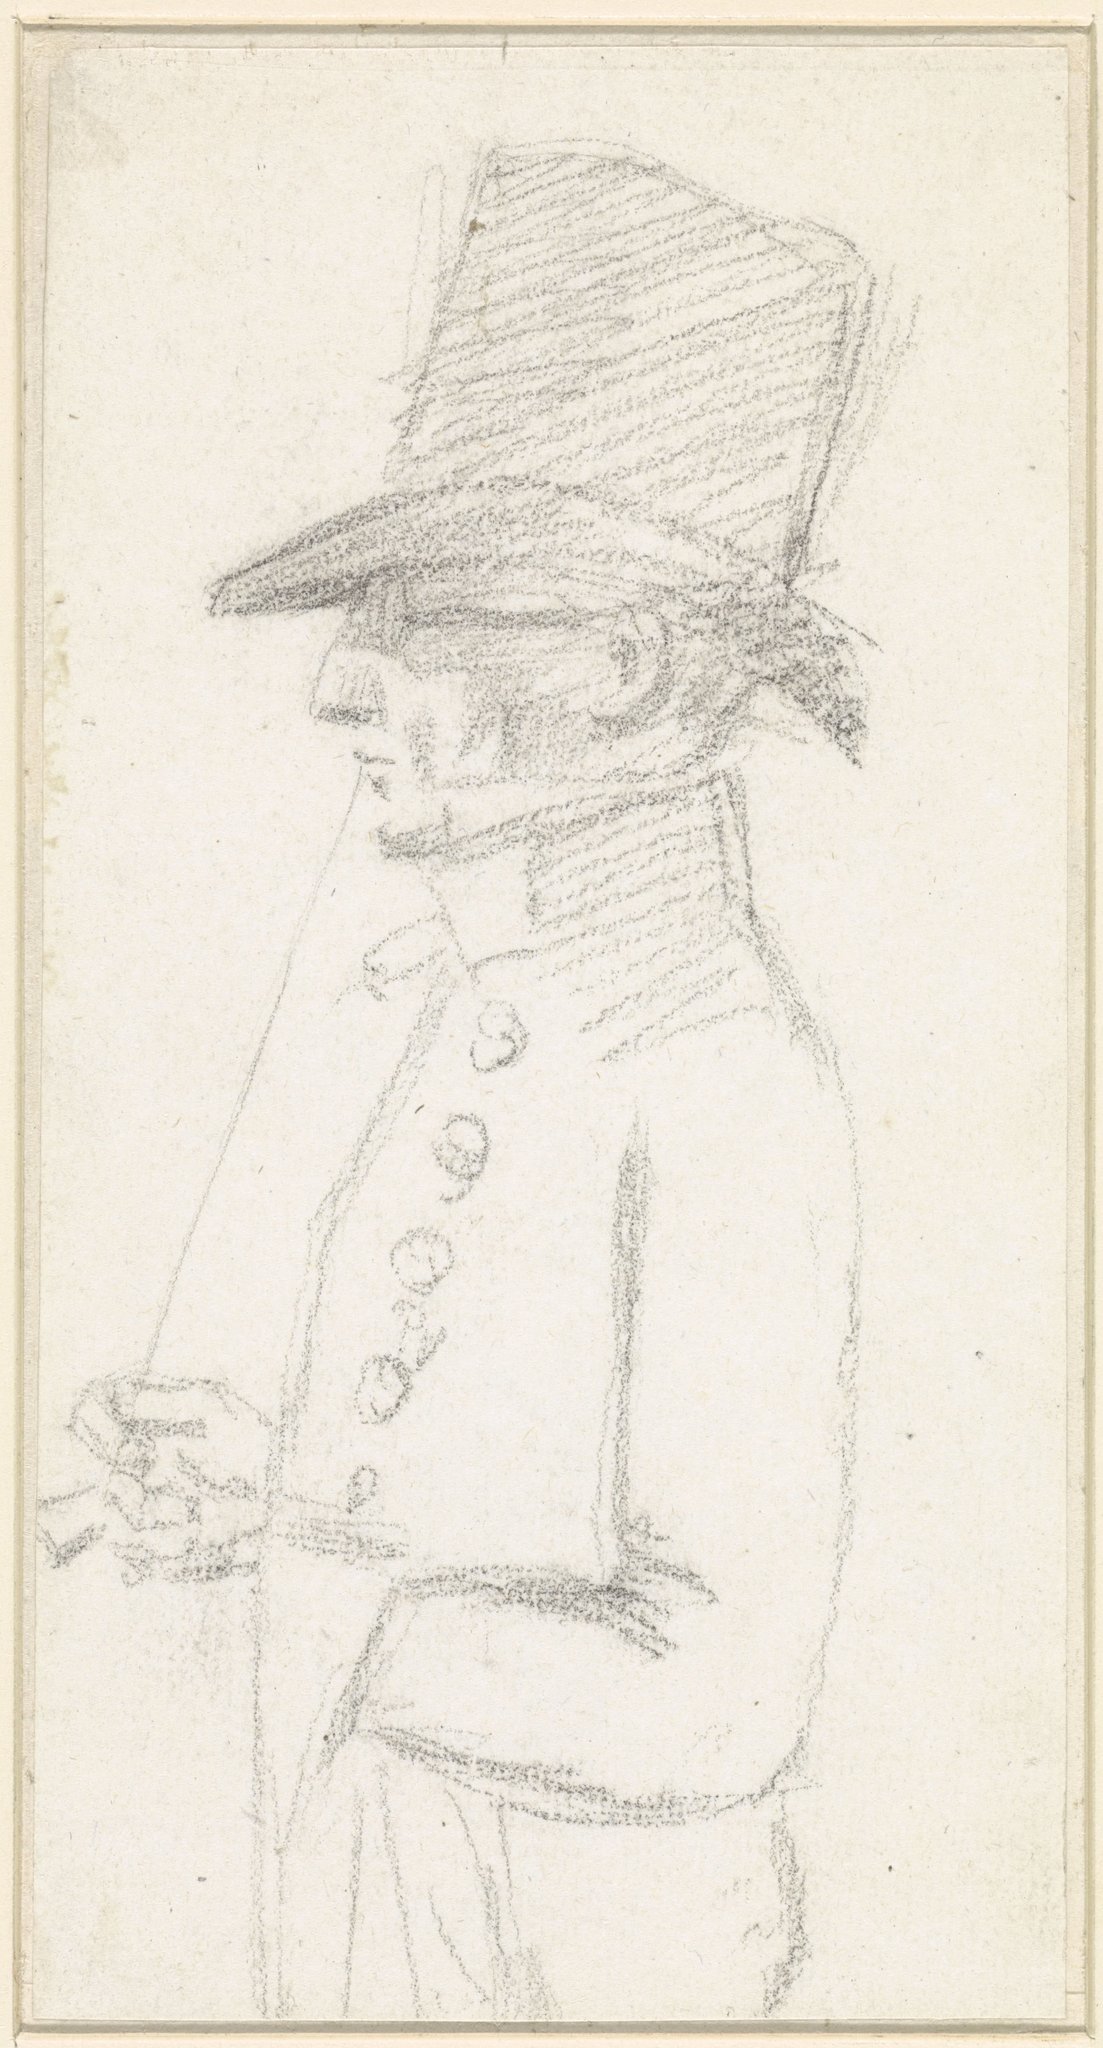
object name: drawing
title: Portret van Hendrik de Flines en profiel met hoed en bril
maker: Anonymous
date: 1700-1800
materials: chalk, paper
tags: hendrik de flines, historical persons, portrait, self-portrait of painter, portrait, self-portrait of artist, portrait, self-portrait of draughtsman